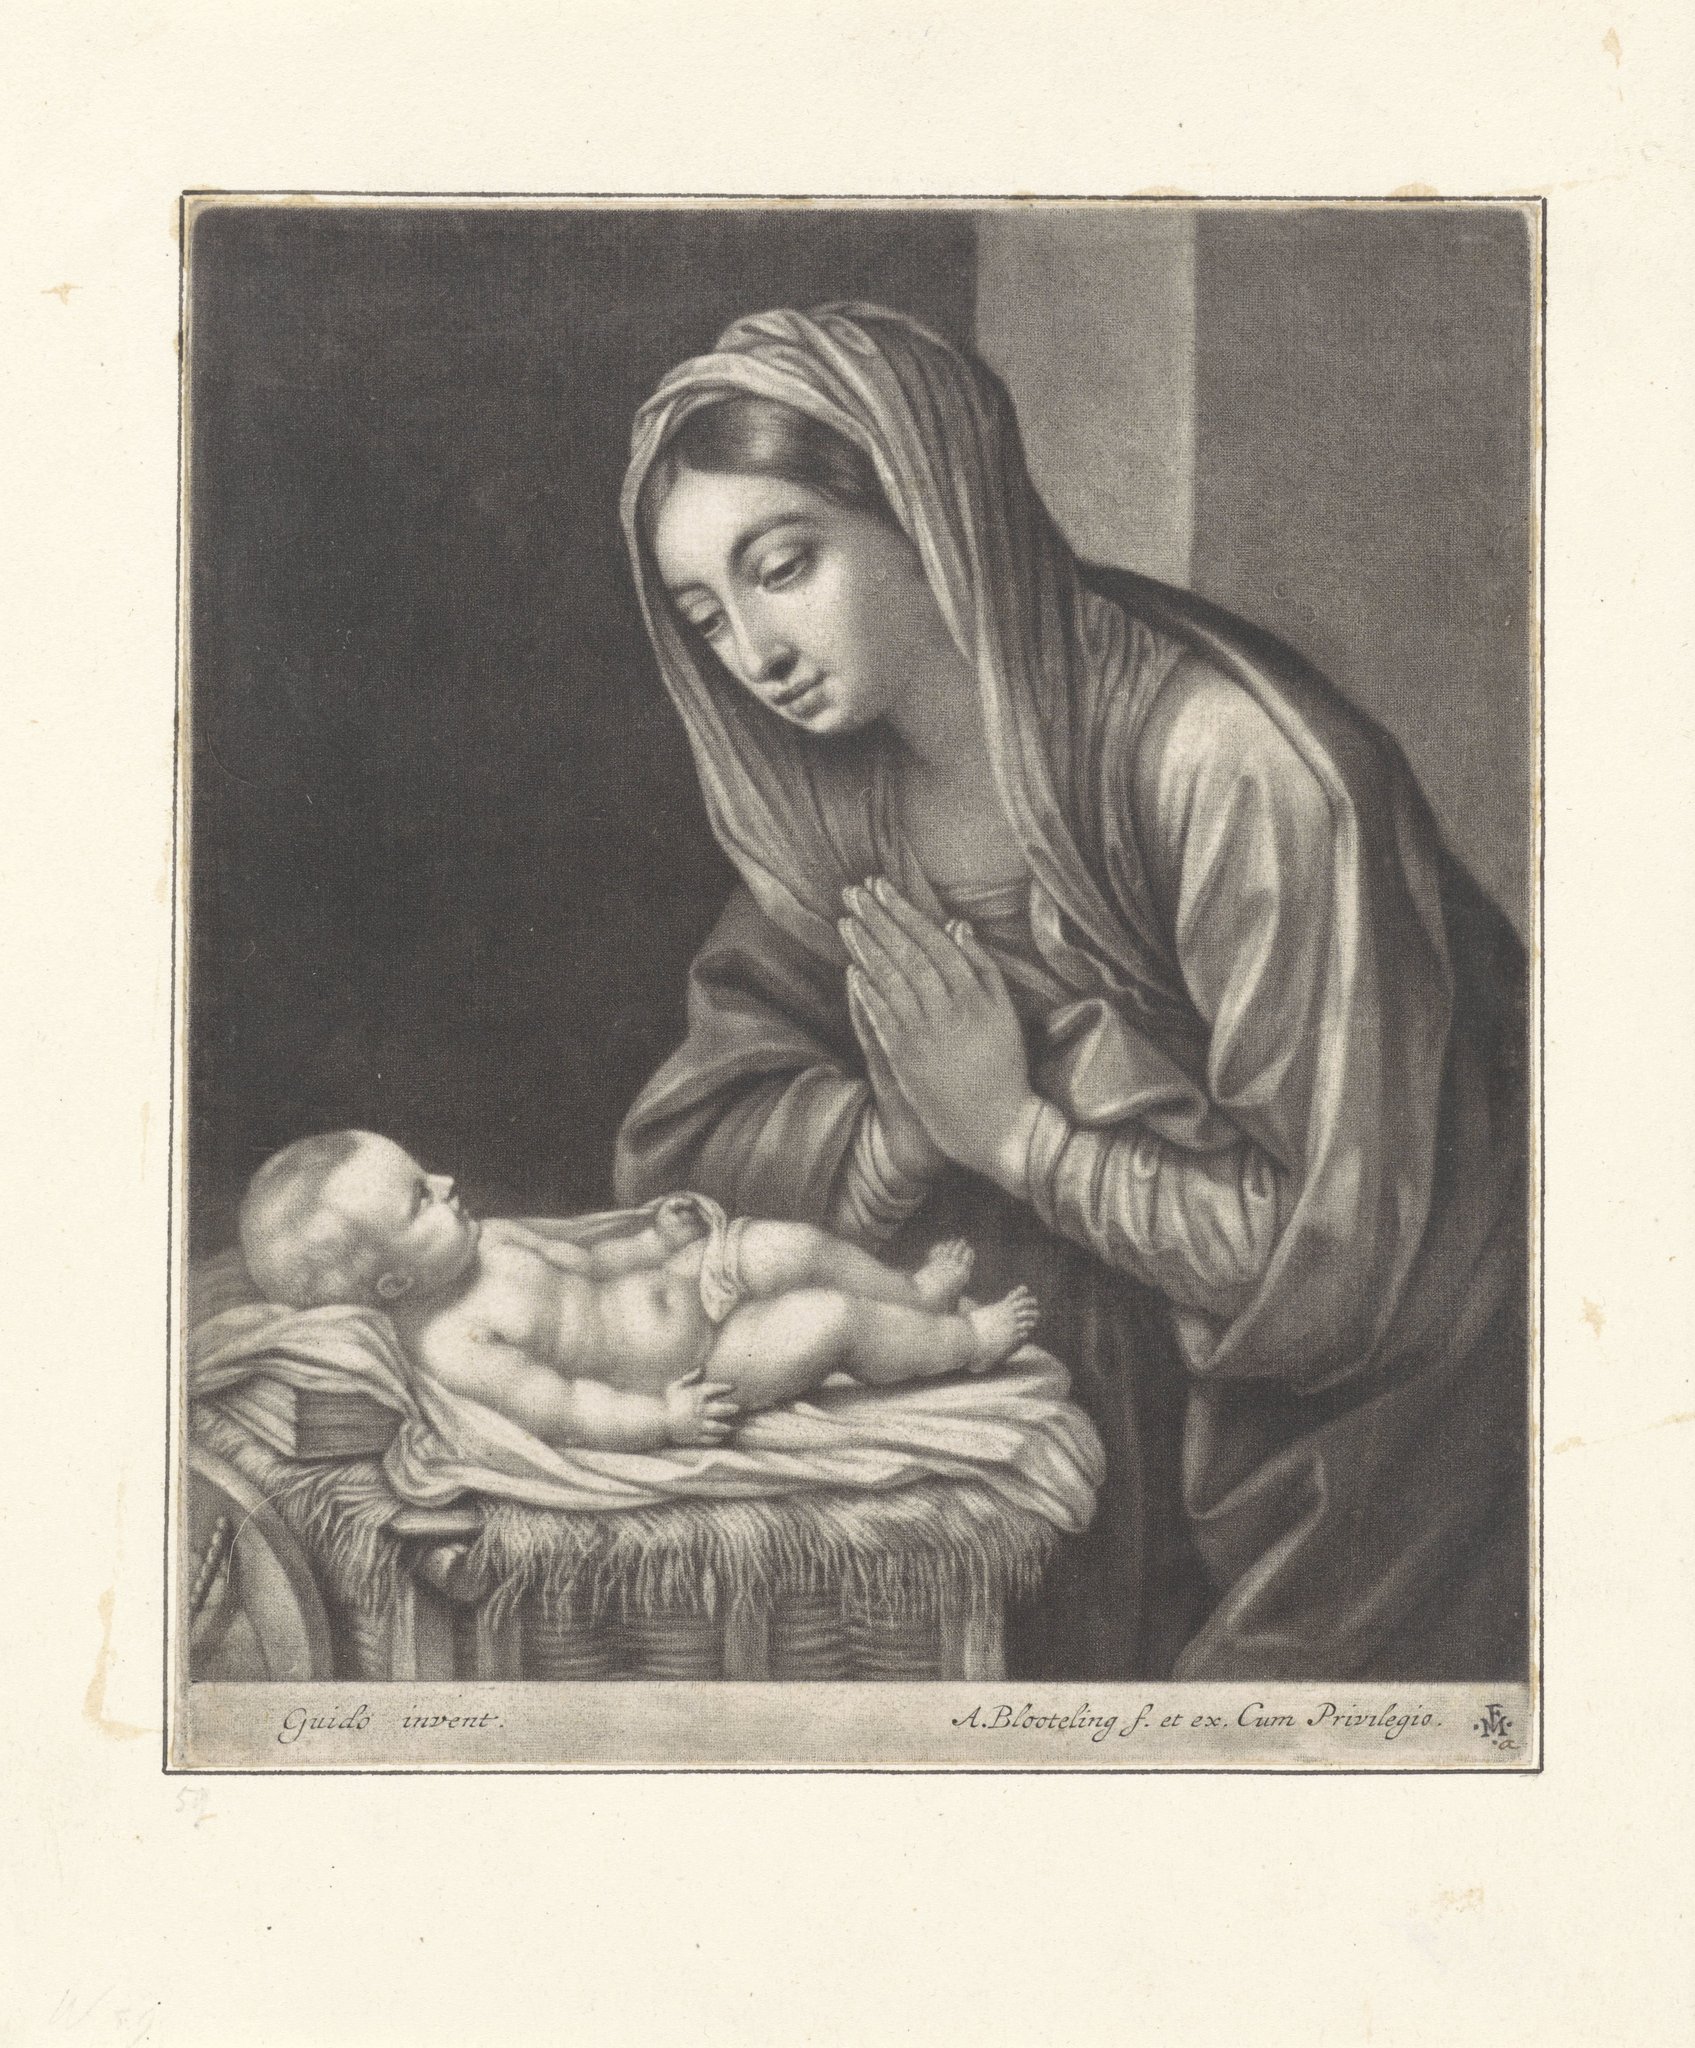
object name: print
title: Maria aanbidt het Christuskind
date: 1652-1690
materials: paper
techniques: engraving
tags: madonna: i.e. mary with the christ-child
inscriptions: collector's mark: Lugt 1034, collector's mark: Lugt 2228